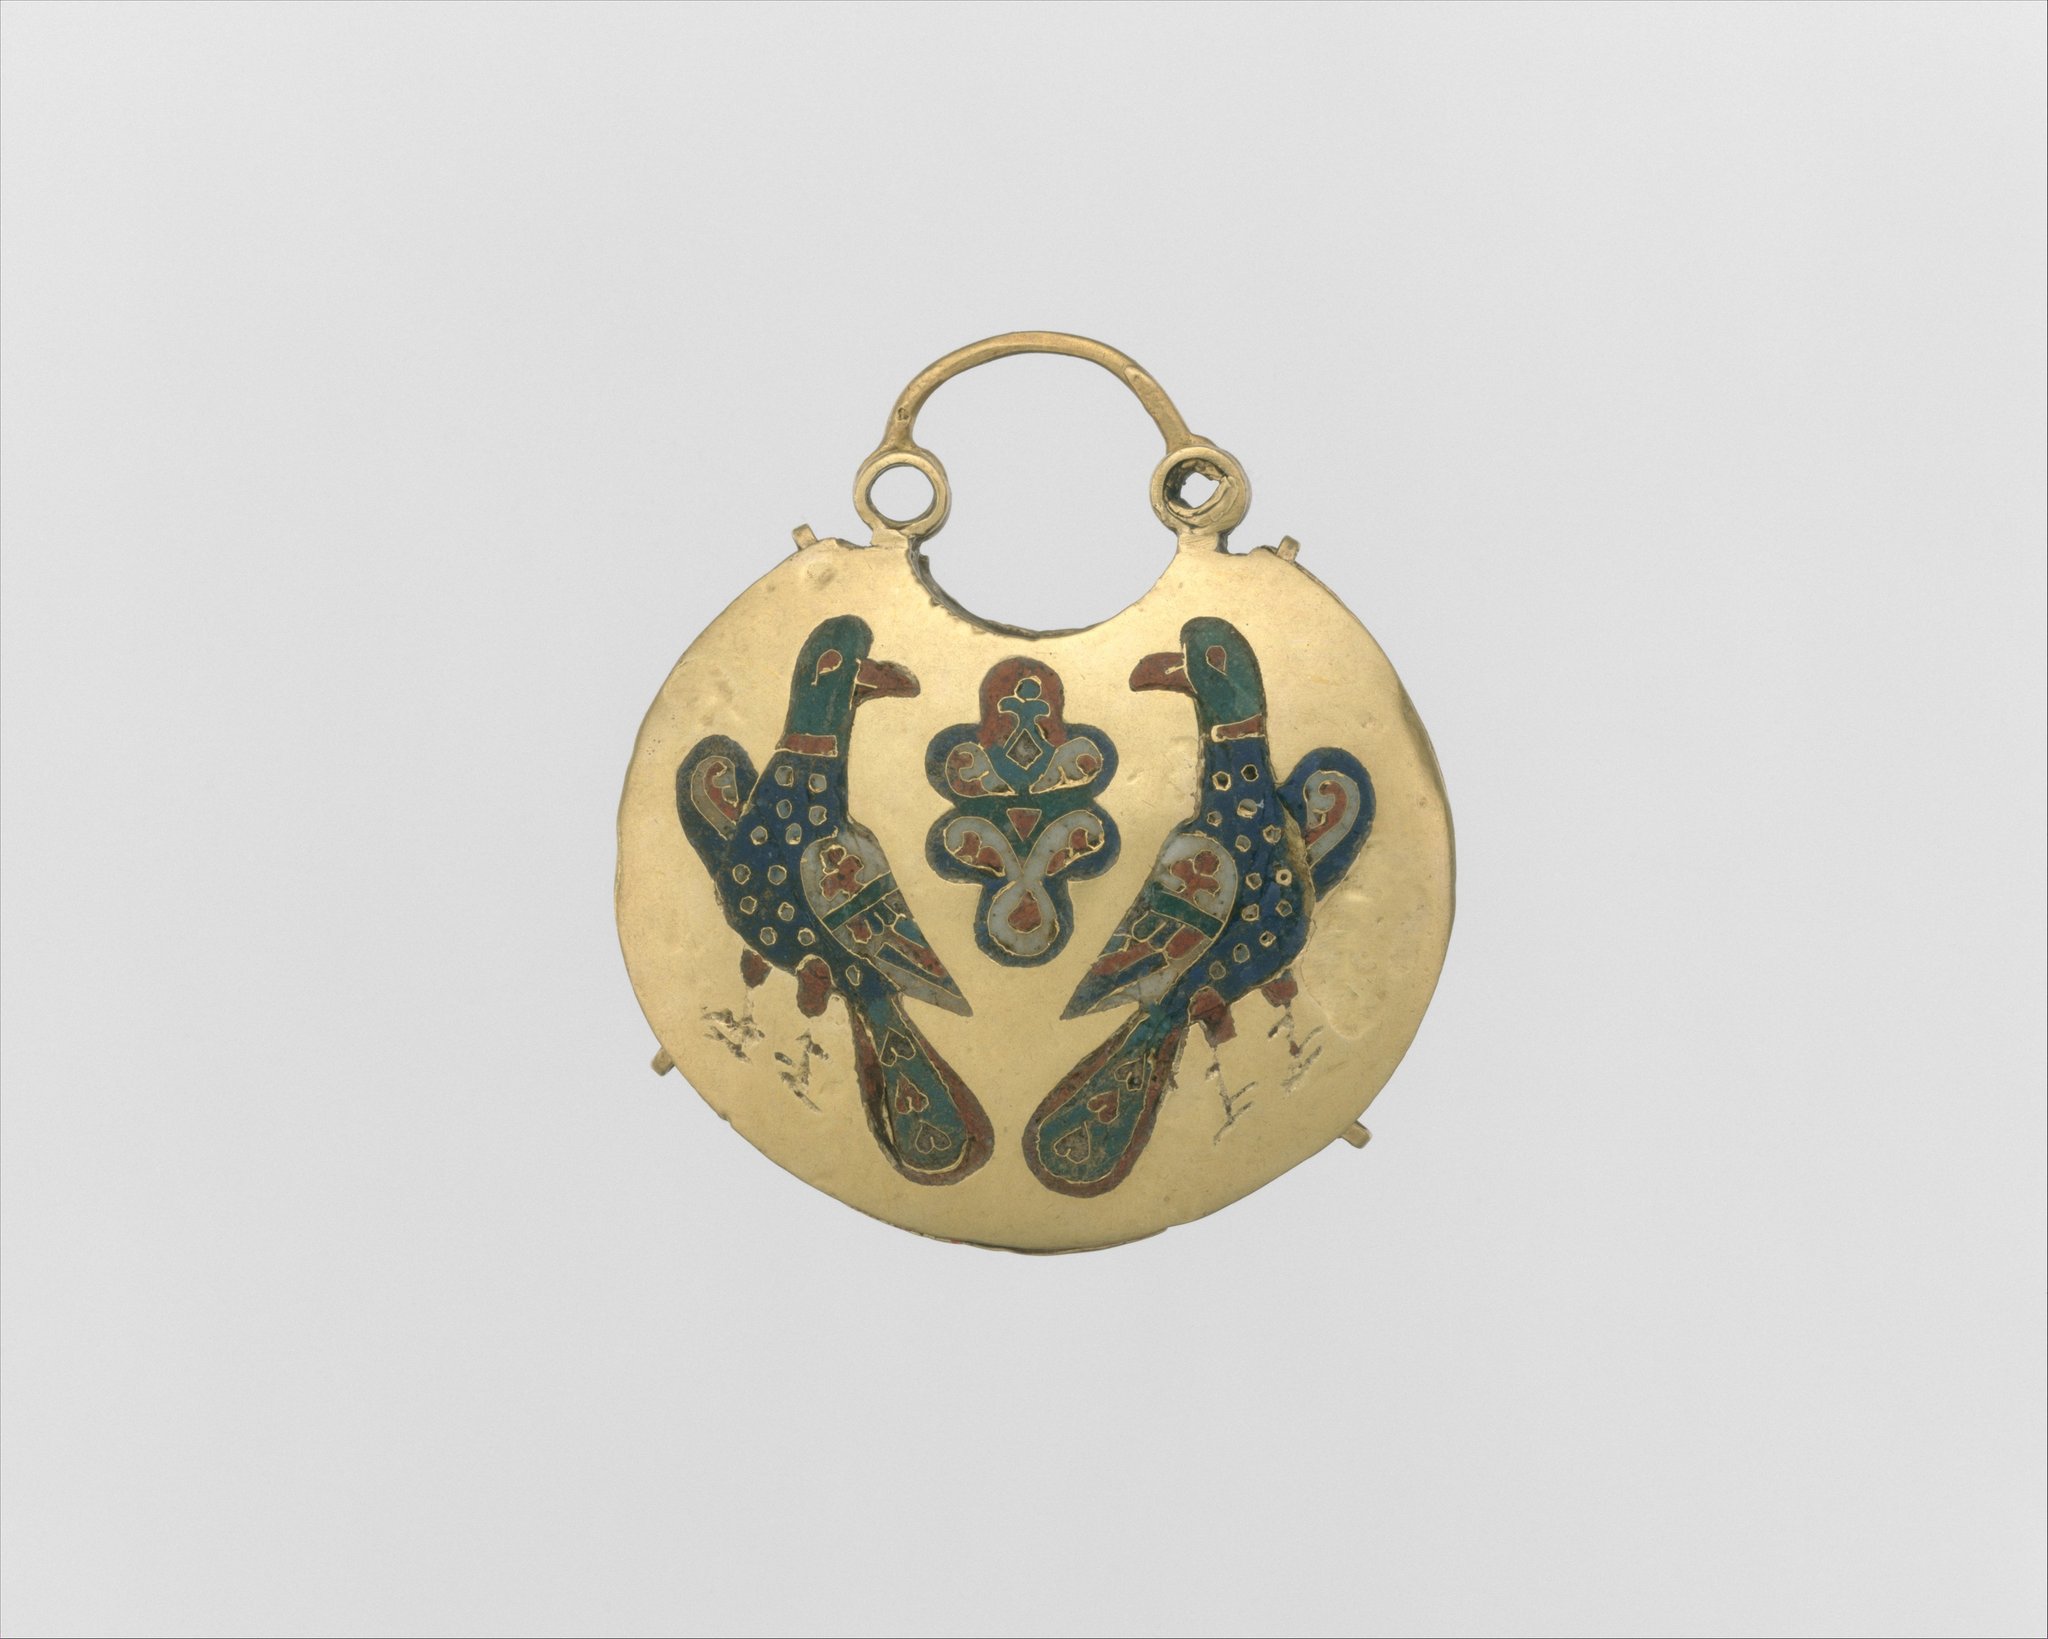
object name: temple pendant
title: Temple Pendant with Two Birds Flanking a Tree of Life (front) and Geometric and Vegetal Motifs (back)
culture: kyivan rus’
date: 1001-1200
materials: enamel, gold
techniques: enamel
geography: ukraine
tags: birds